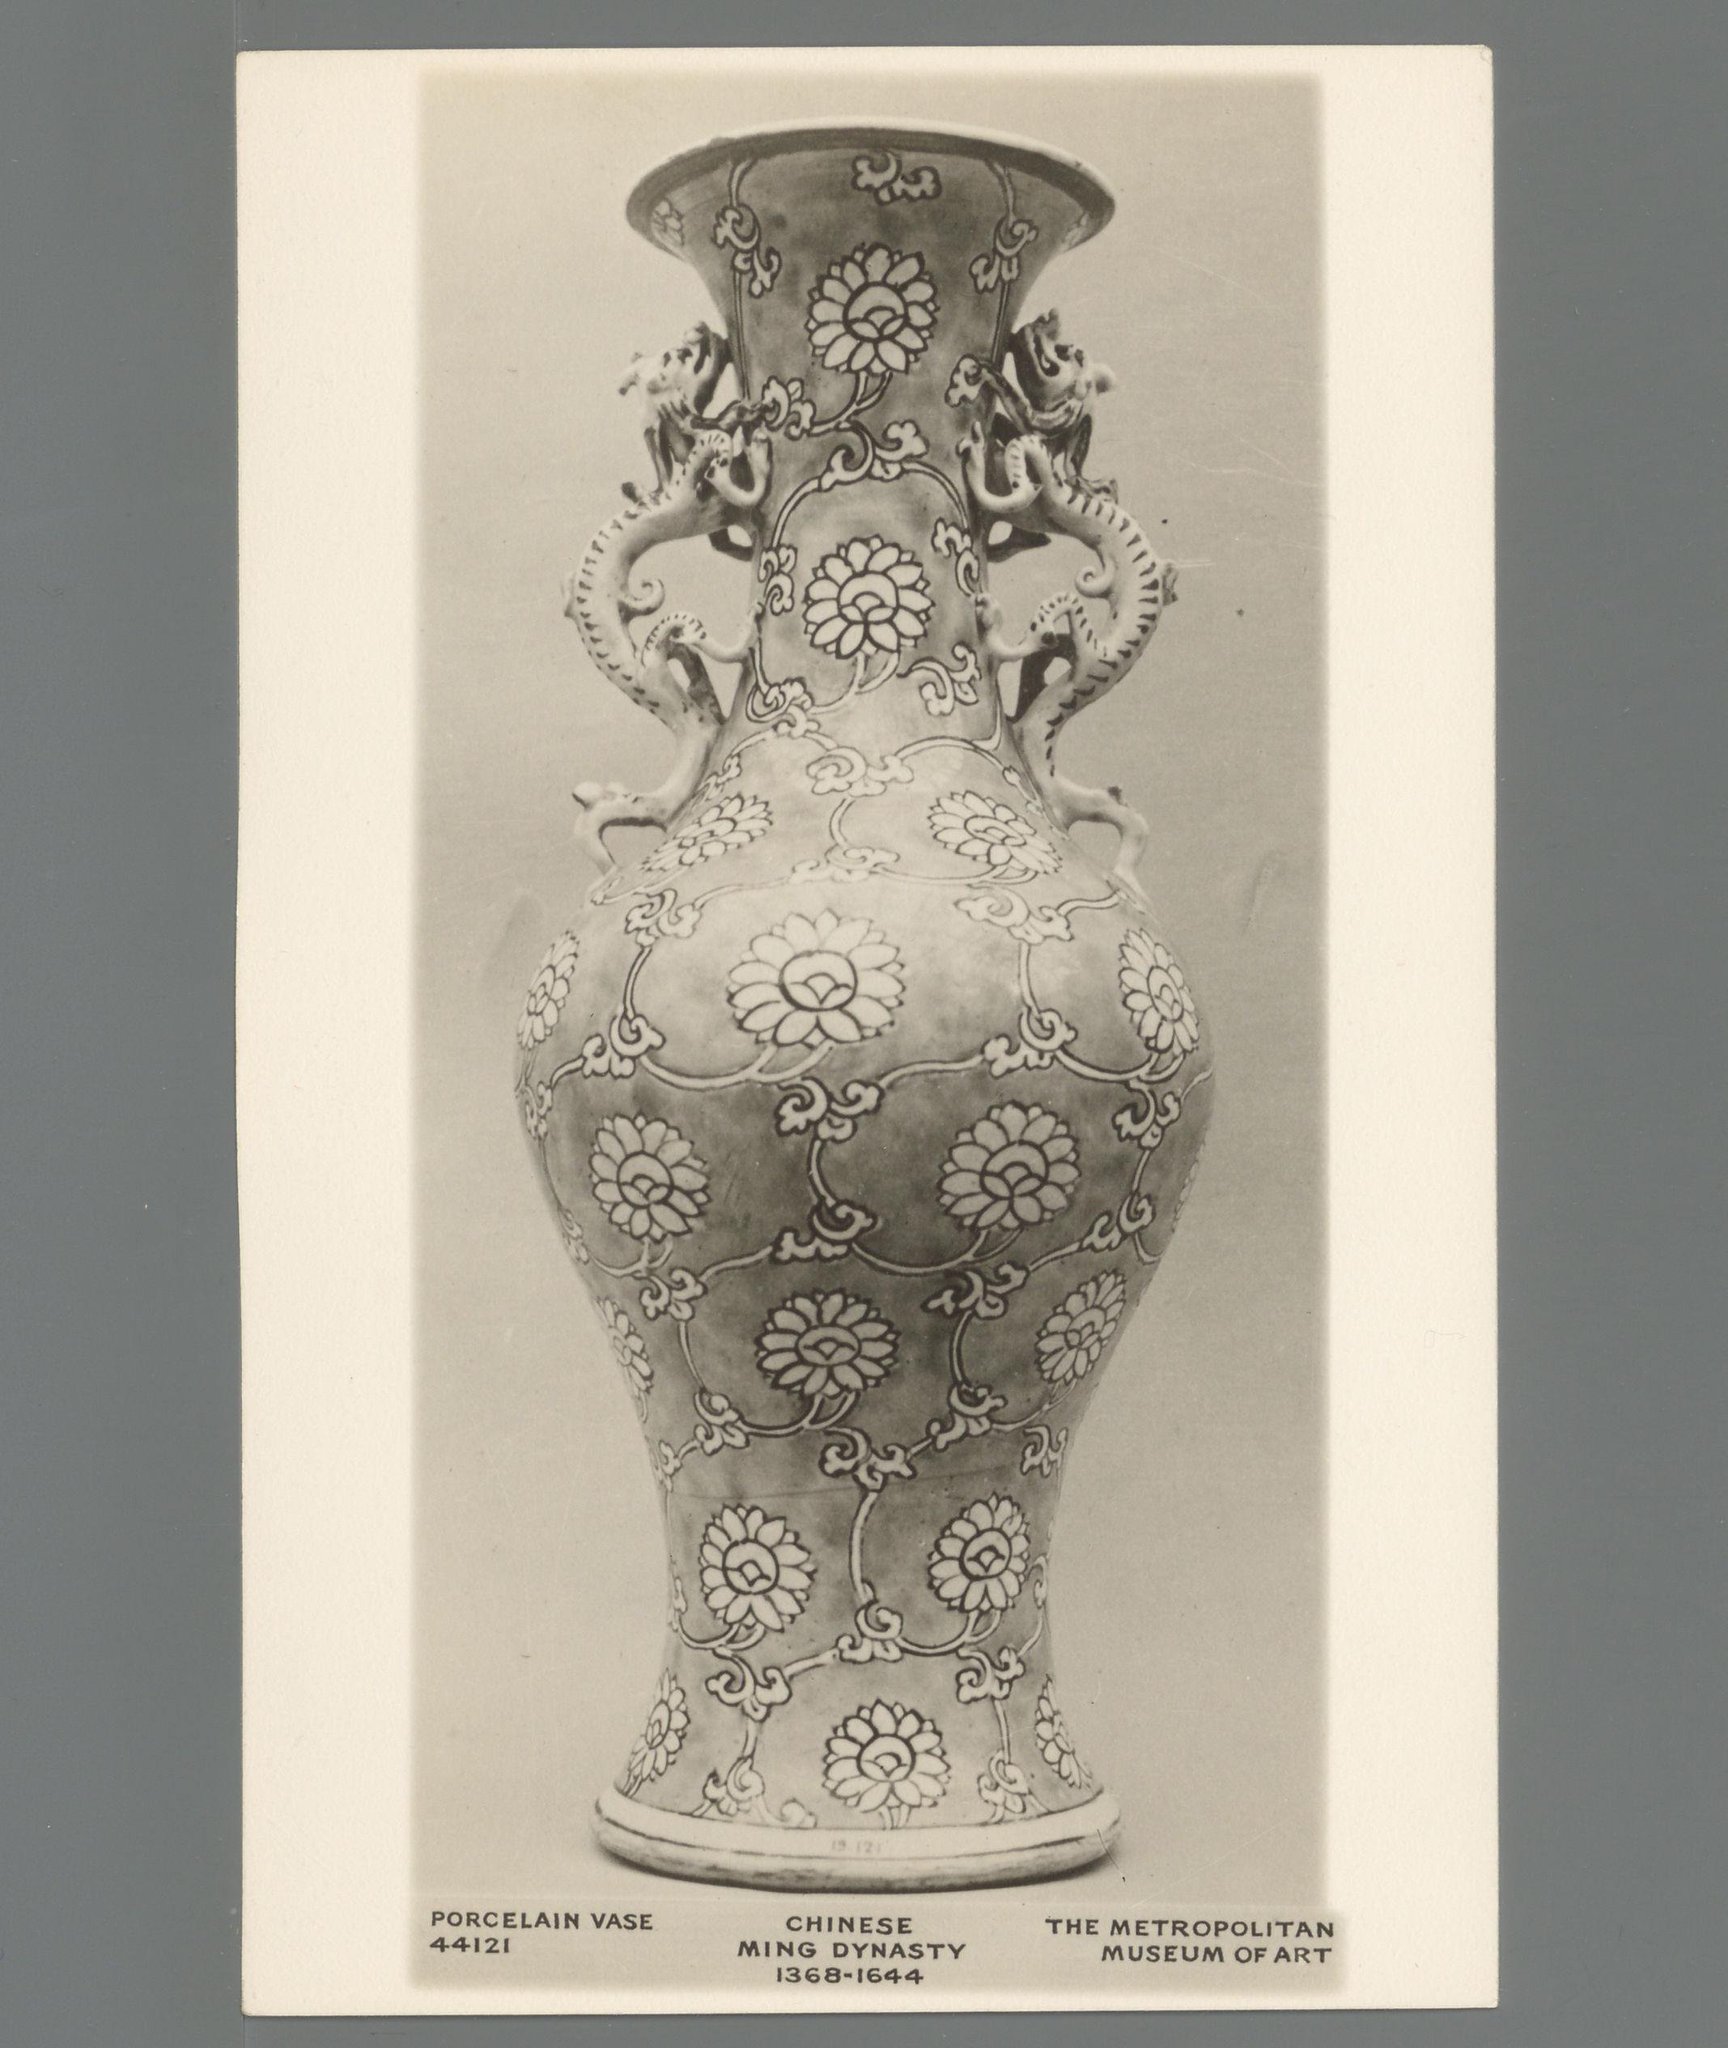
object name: ansichtkaart, prentbriefkaart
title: Porcelain Vase. Chinese Ming Dynasty 1368 - 1644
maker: Anonymous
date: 1919-1940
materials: photographic support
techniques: photography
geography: new york city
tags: container of ceramics: jar, jug, pot, vase, ornamenting, decorating ~ applied arts